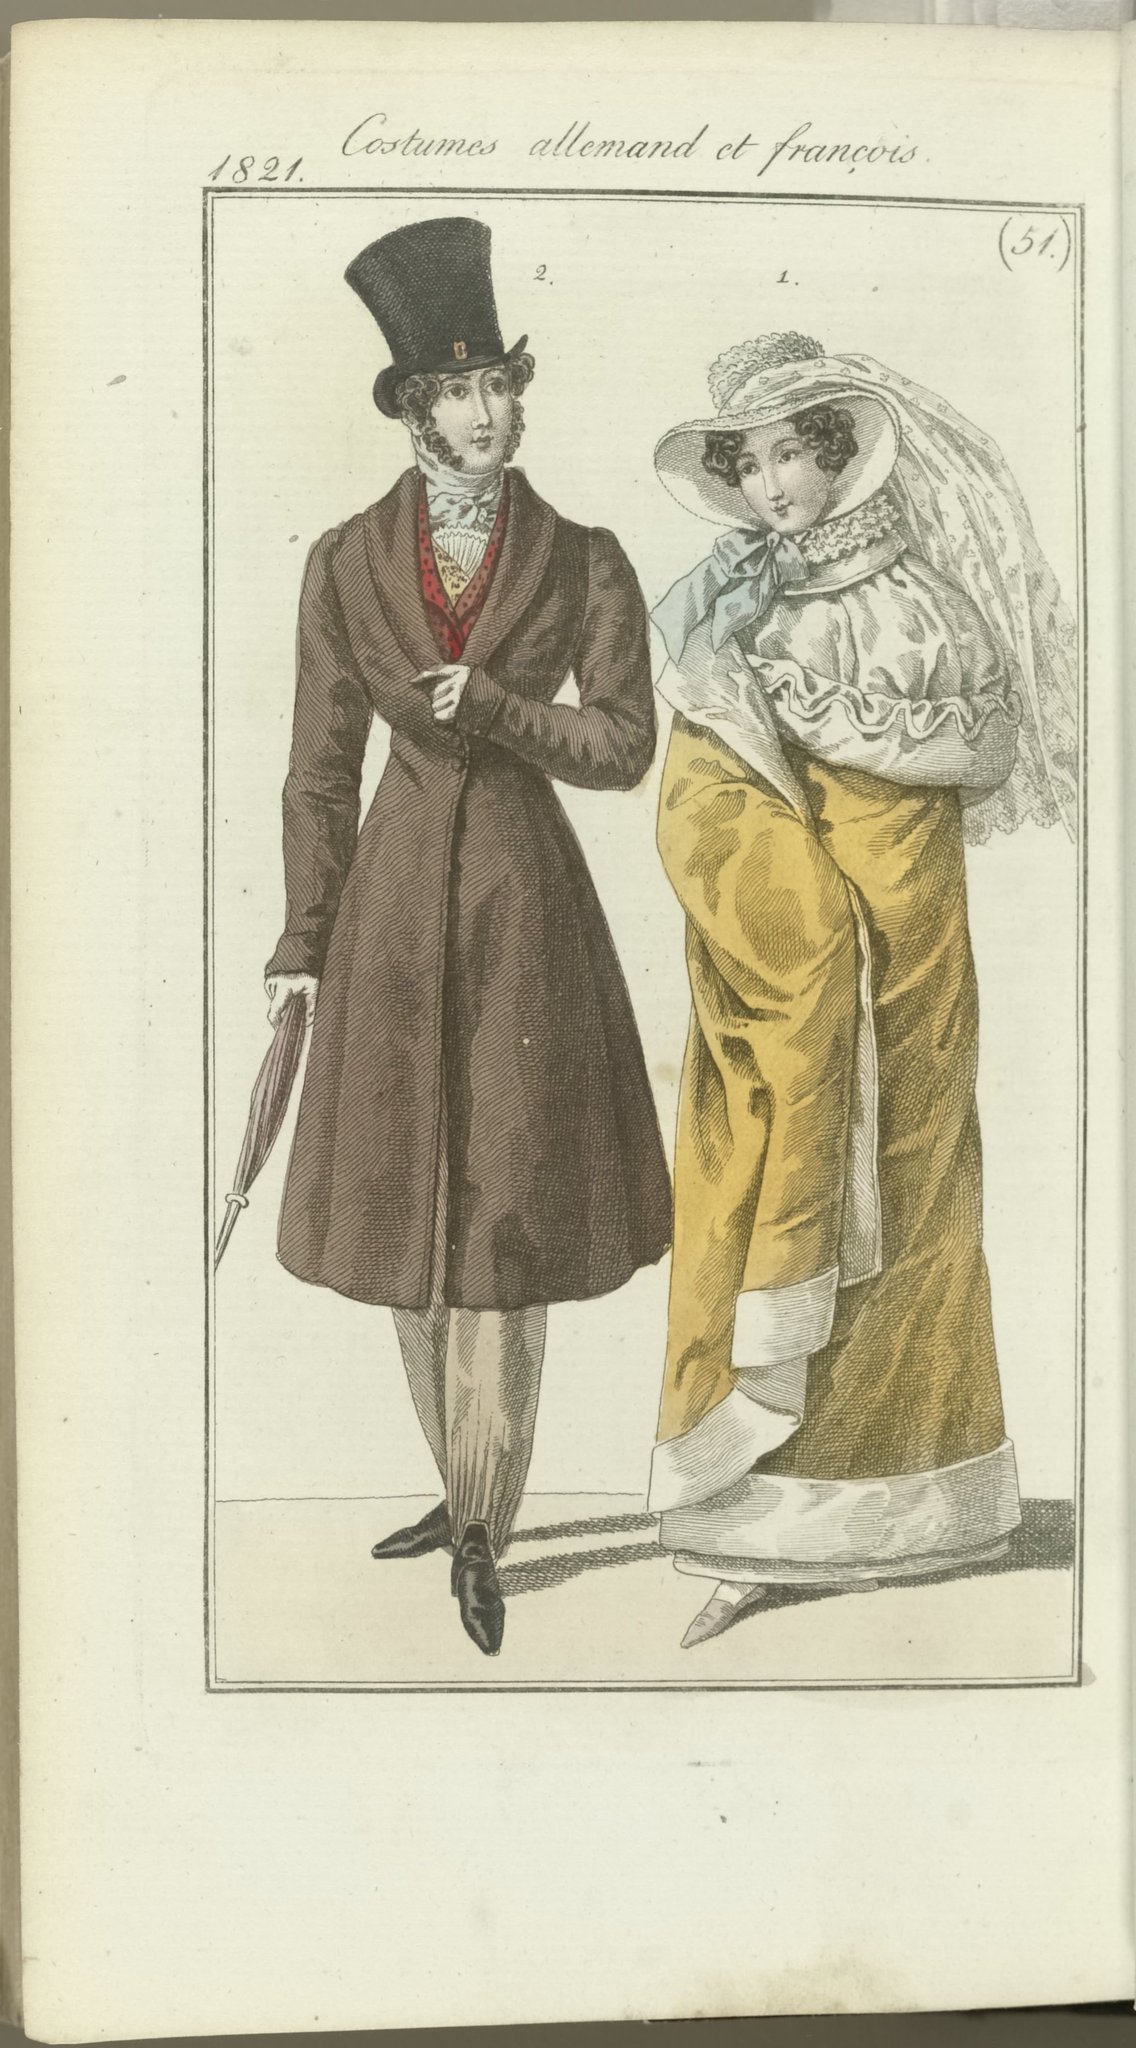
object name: fashion print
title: Journal des Dames et des Modes, editie Frankfurt 16 decembre 1821, Costumes allemand et françois (51)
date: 1821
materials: paper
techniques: engraving, hand coloring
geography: frankfurt am main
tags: neck-gear ~ clothing (cravat) (+ men's clothes), veil (+ lace used for clothes), neck-gear ~ clothing (shawl collar) (+ men's clothes), trousers, breeches, etc. (pantalon) (+ men's clothes), coat (+ men's clothes), cape (pelisse) (+ women's clothes), fashion plates, head-gear: hat (+ women's clothes), walking-stick, staff, cane (+ men's clothes)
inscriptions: title: ‘Costumes allemand et françois.’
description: De begeleidende tekst (p. 679) vermeldt: Weense Mode: Fig. 1: Hoed van pluche met een voile van kant. Pelisse van geel fluweel, gegarneerd met wit pluche, met een capuchon van wit fluweel. Witte handschoenen. Gele schoenen. Frans kostuum. Fig. 2: Hoge hoed met zeer smalle rand. Das van zijde. Vest van kasjmier; ondervest van kajsmier. Redingote met sjaal. Pantalon van 'cuir de laine'. De prent maakt deel uit van het modetijdschrift Journal des Dames et des Modes, uitgegeven in Frankfurt als kopie van de Franse editie van Pierre de la Mésangère, Parijs, 1797-1839.